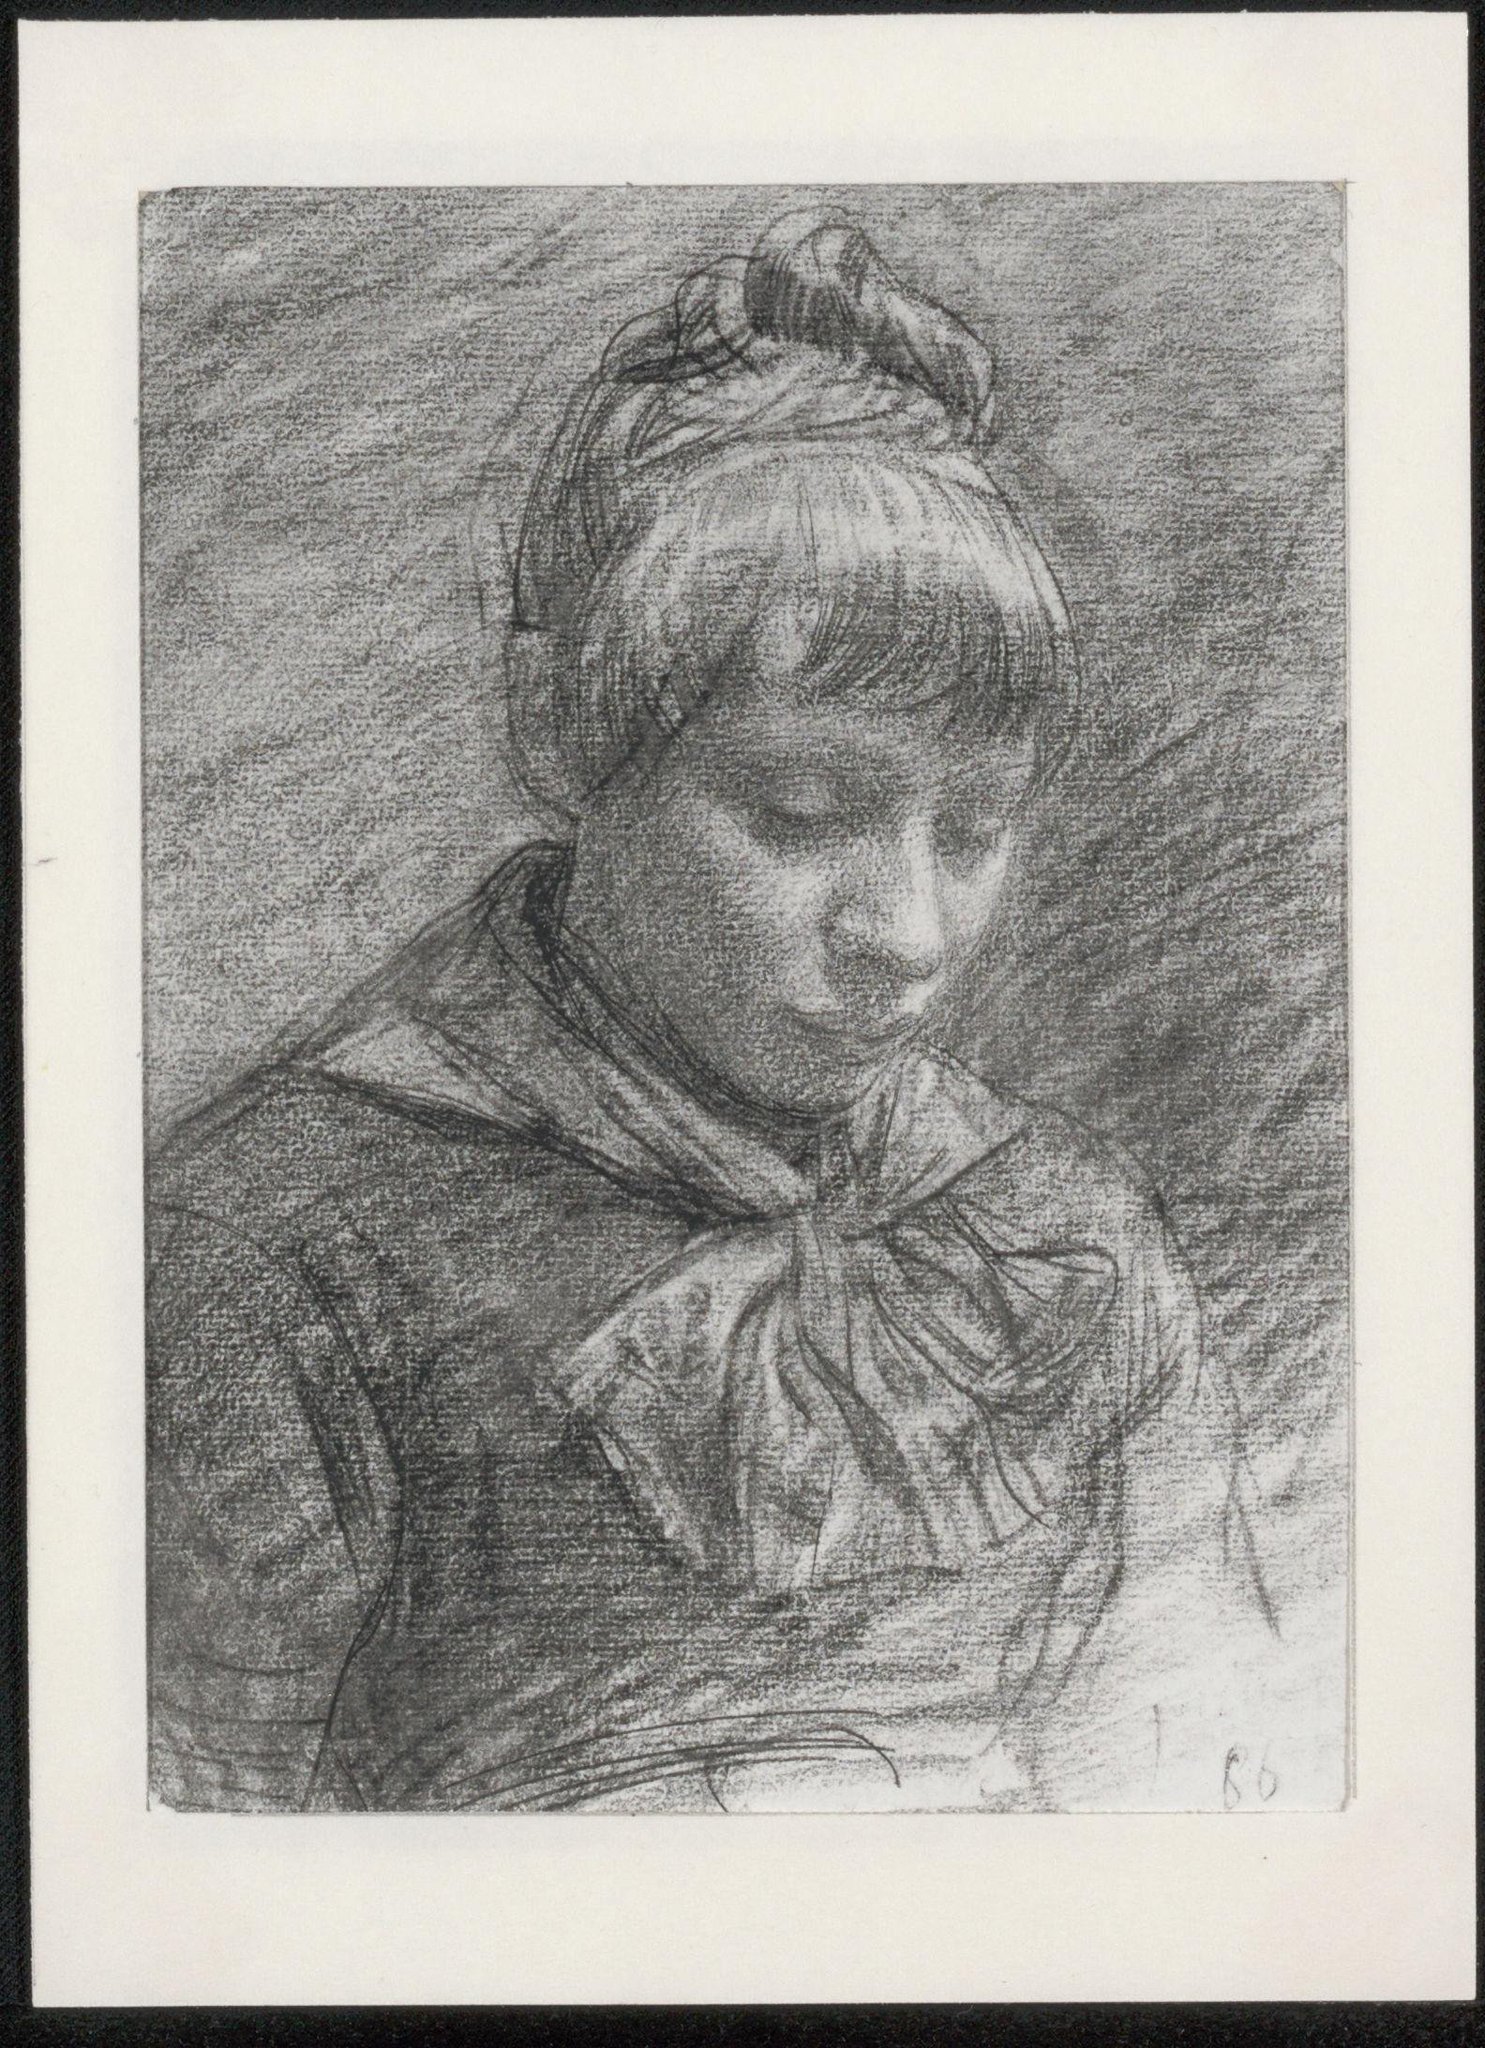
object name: photograph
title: Foto uit archief Jan Veth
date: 1965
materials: photographic support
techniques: photography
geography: amsterdam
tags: dordrecht, painter, designer, jan veth, amsterdam, draughtsman, wally moes, historical persons (portraits and scenes from the life)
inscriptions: collector's mark: ‘RPK’